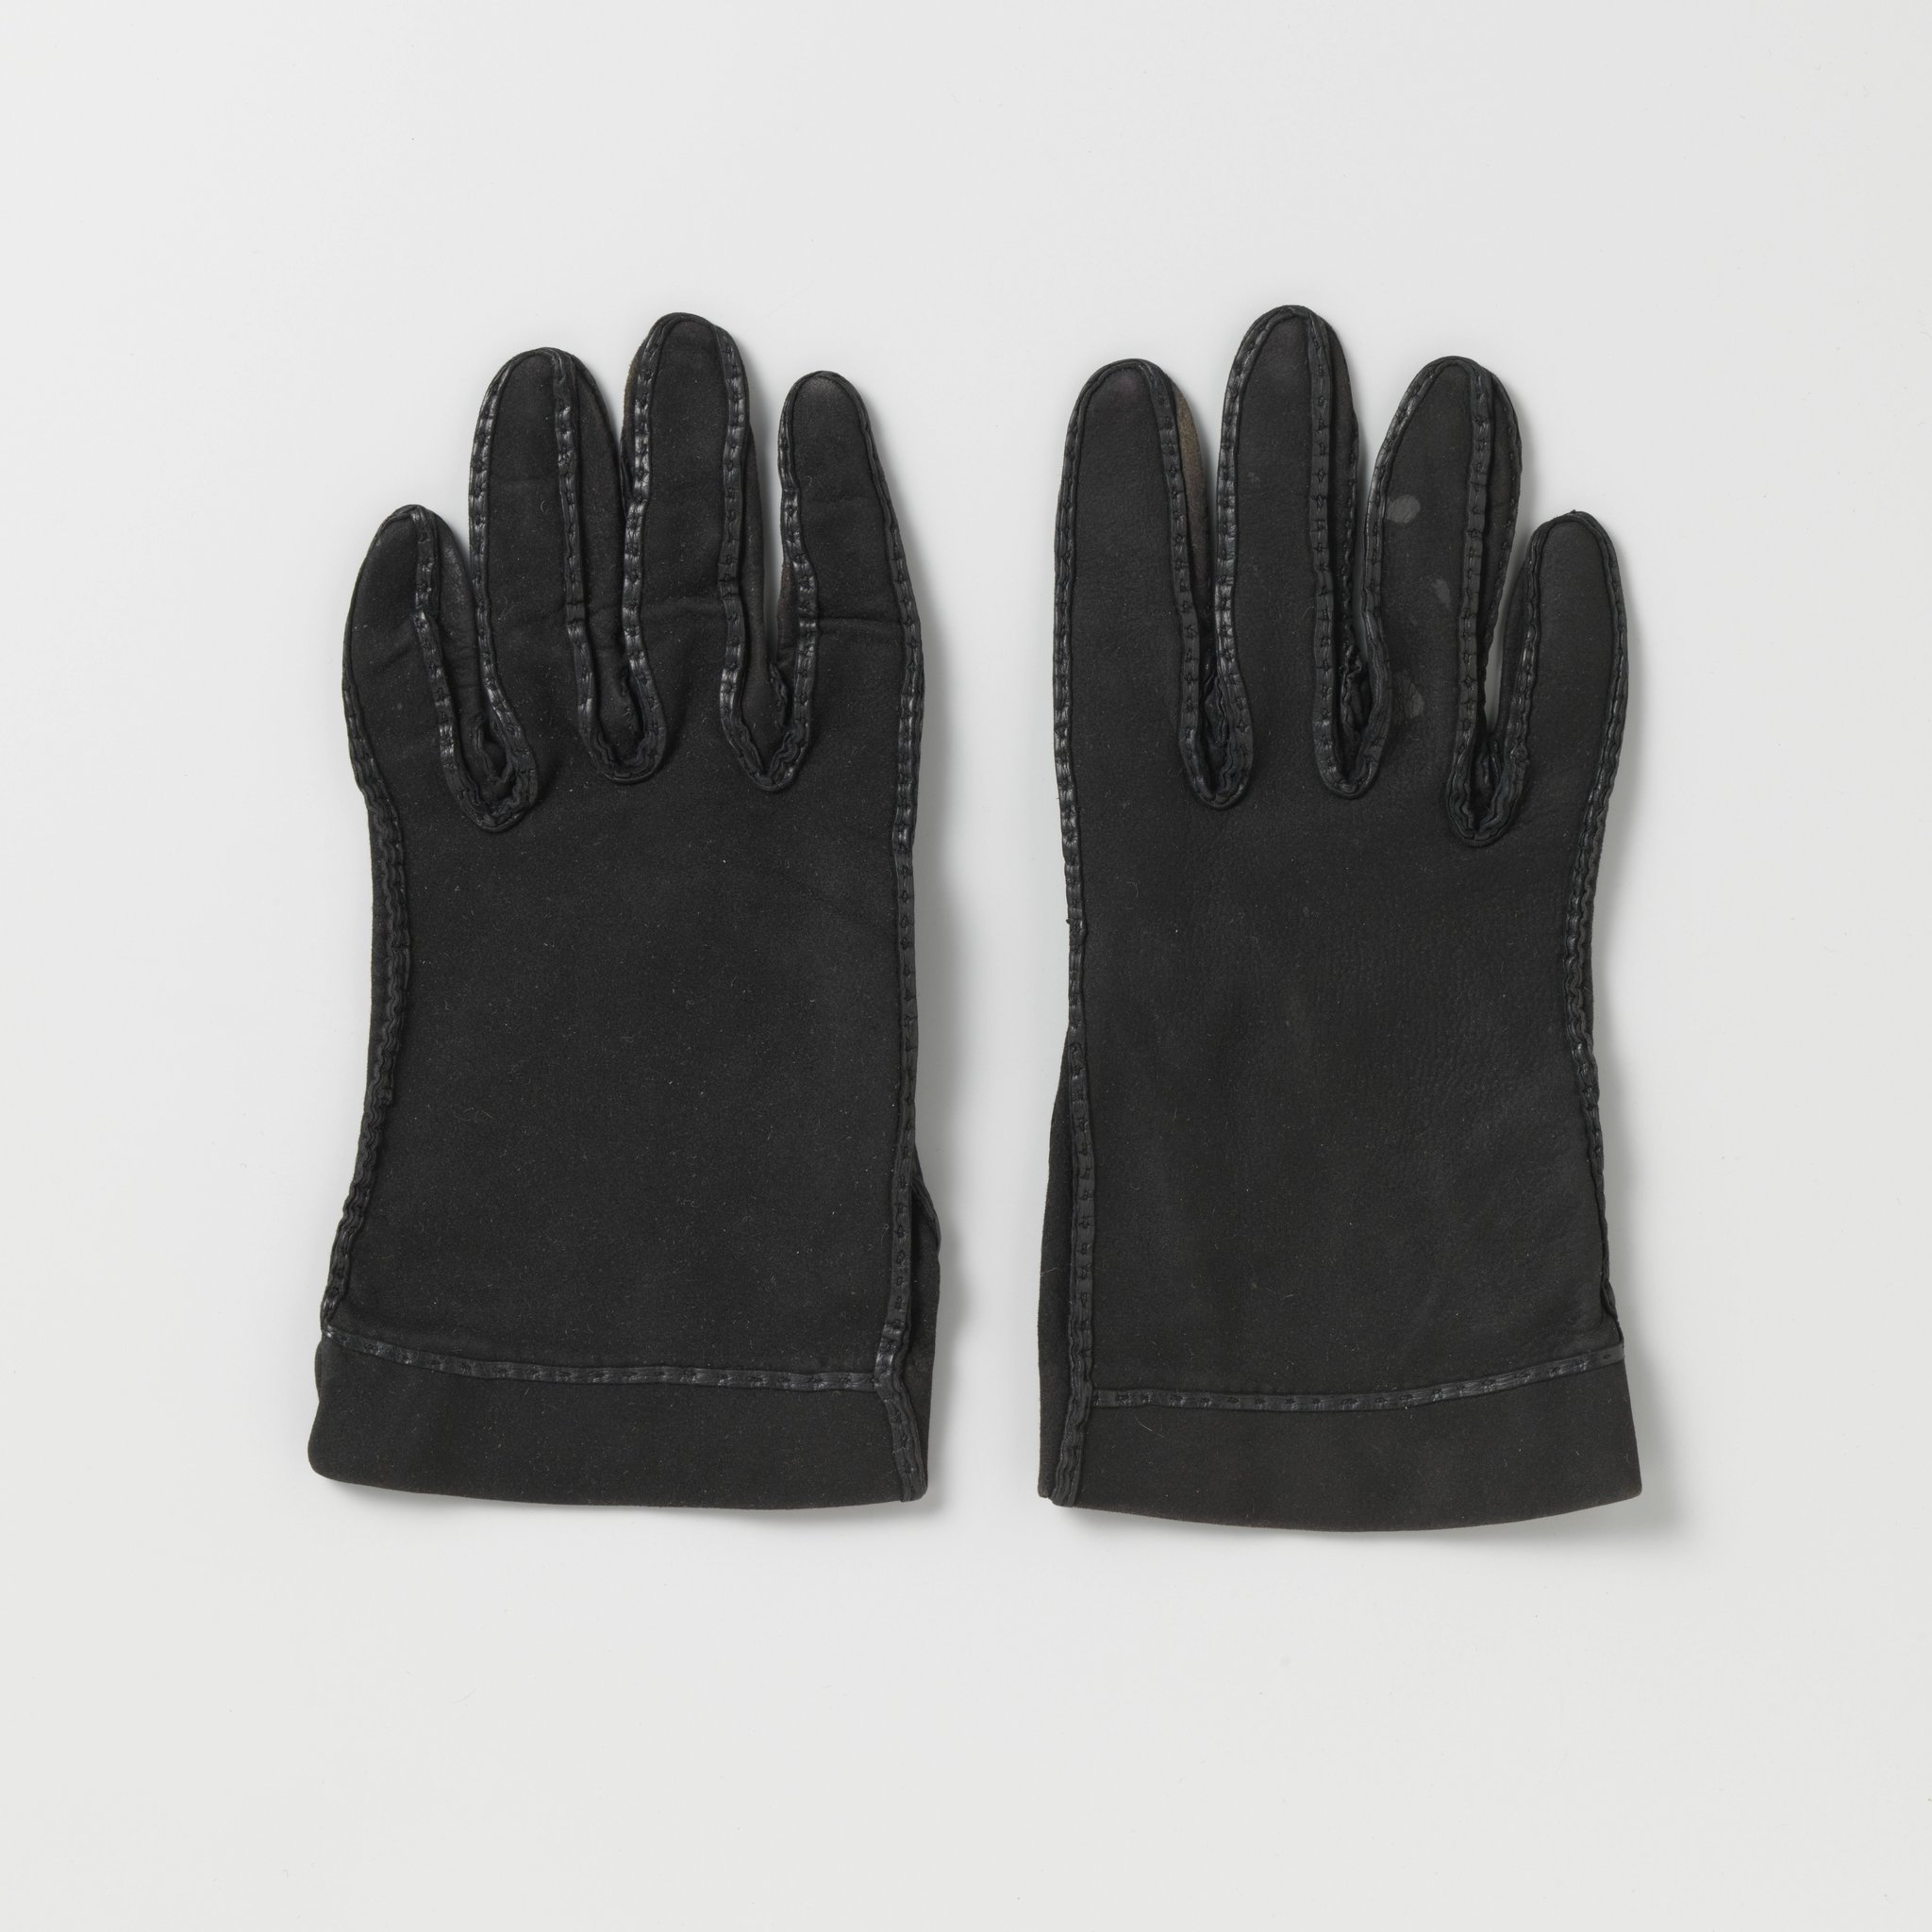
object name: clothing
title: Rechterhandschoen van zwarte suède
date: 1950-1975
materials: leather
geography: netherlands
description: Rechterhandschoen van zwarte suède. Langs de randen afgezet met een zwart leren bies.